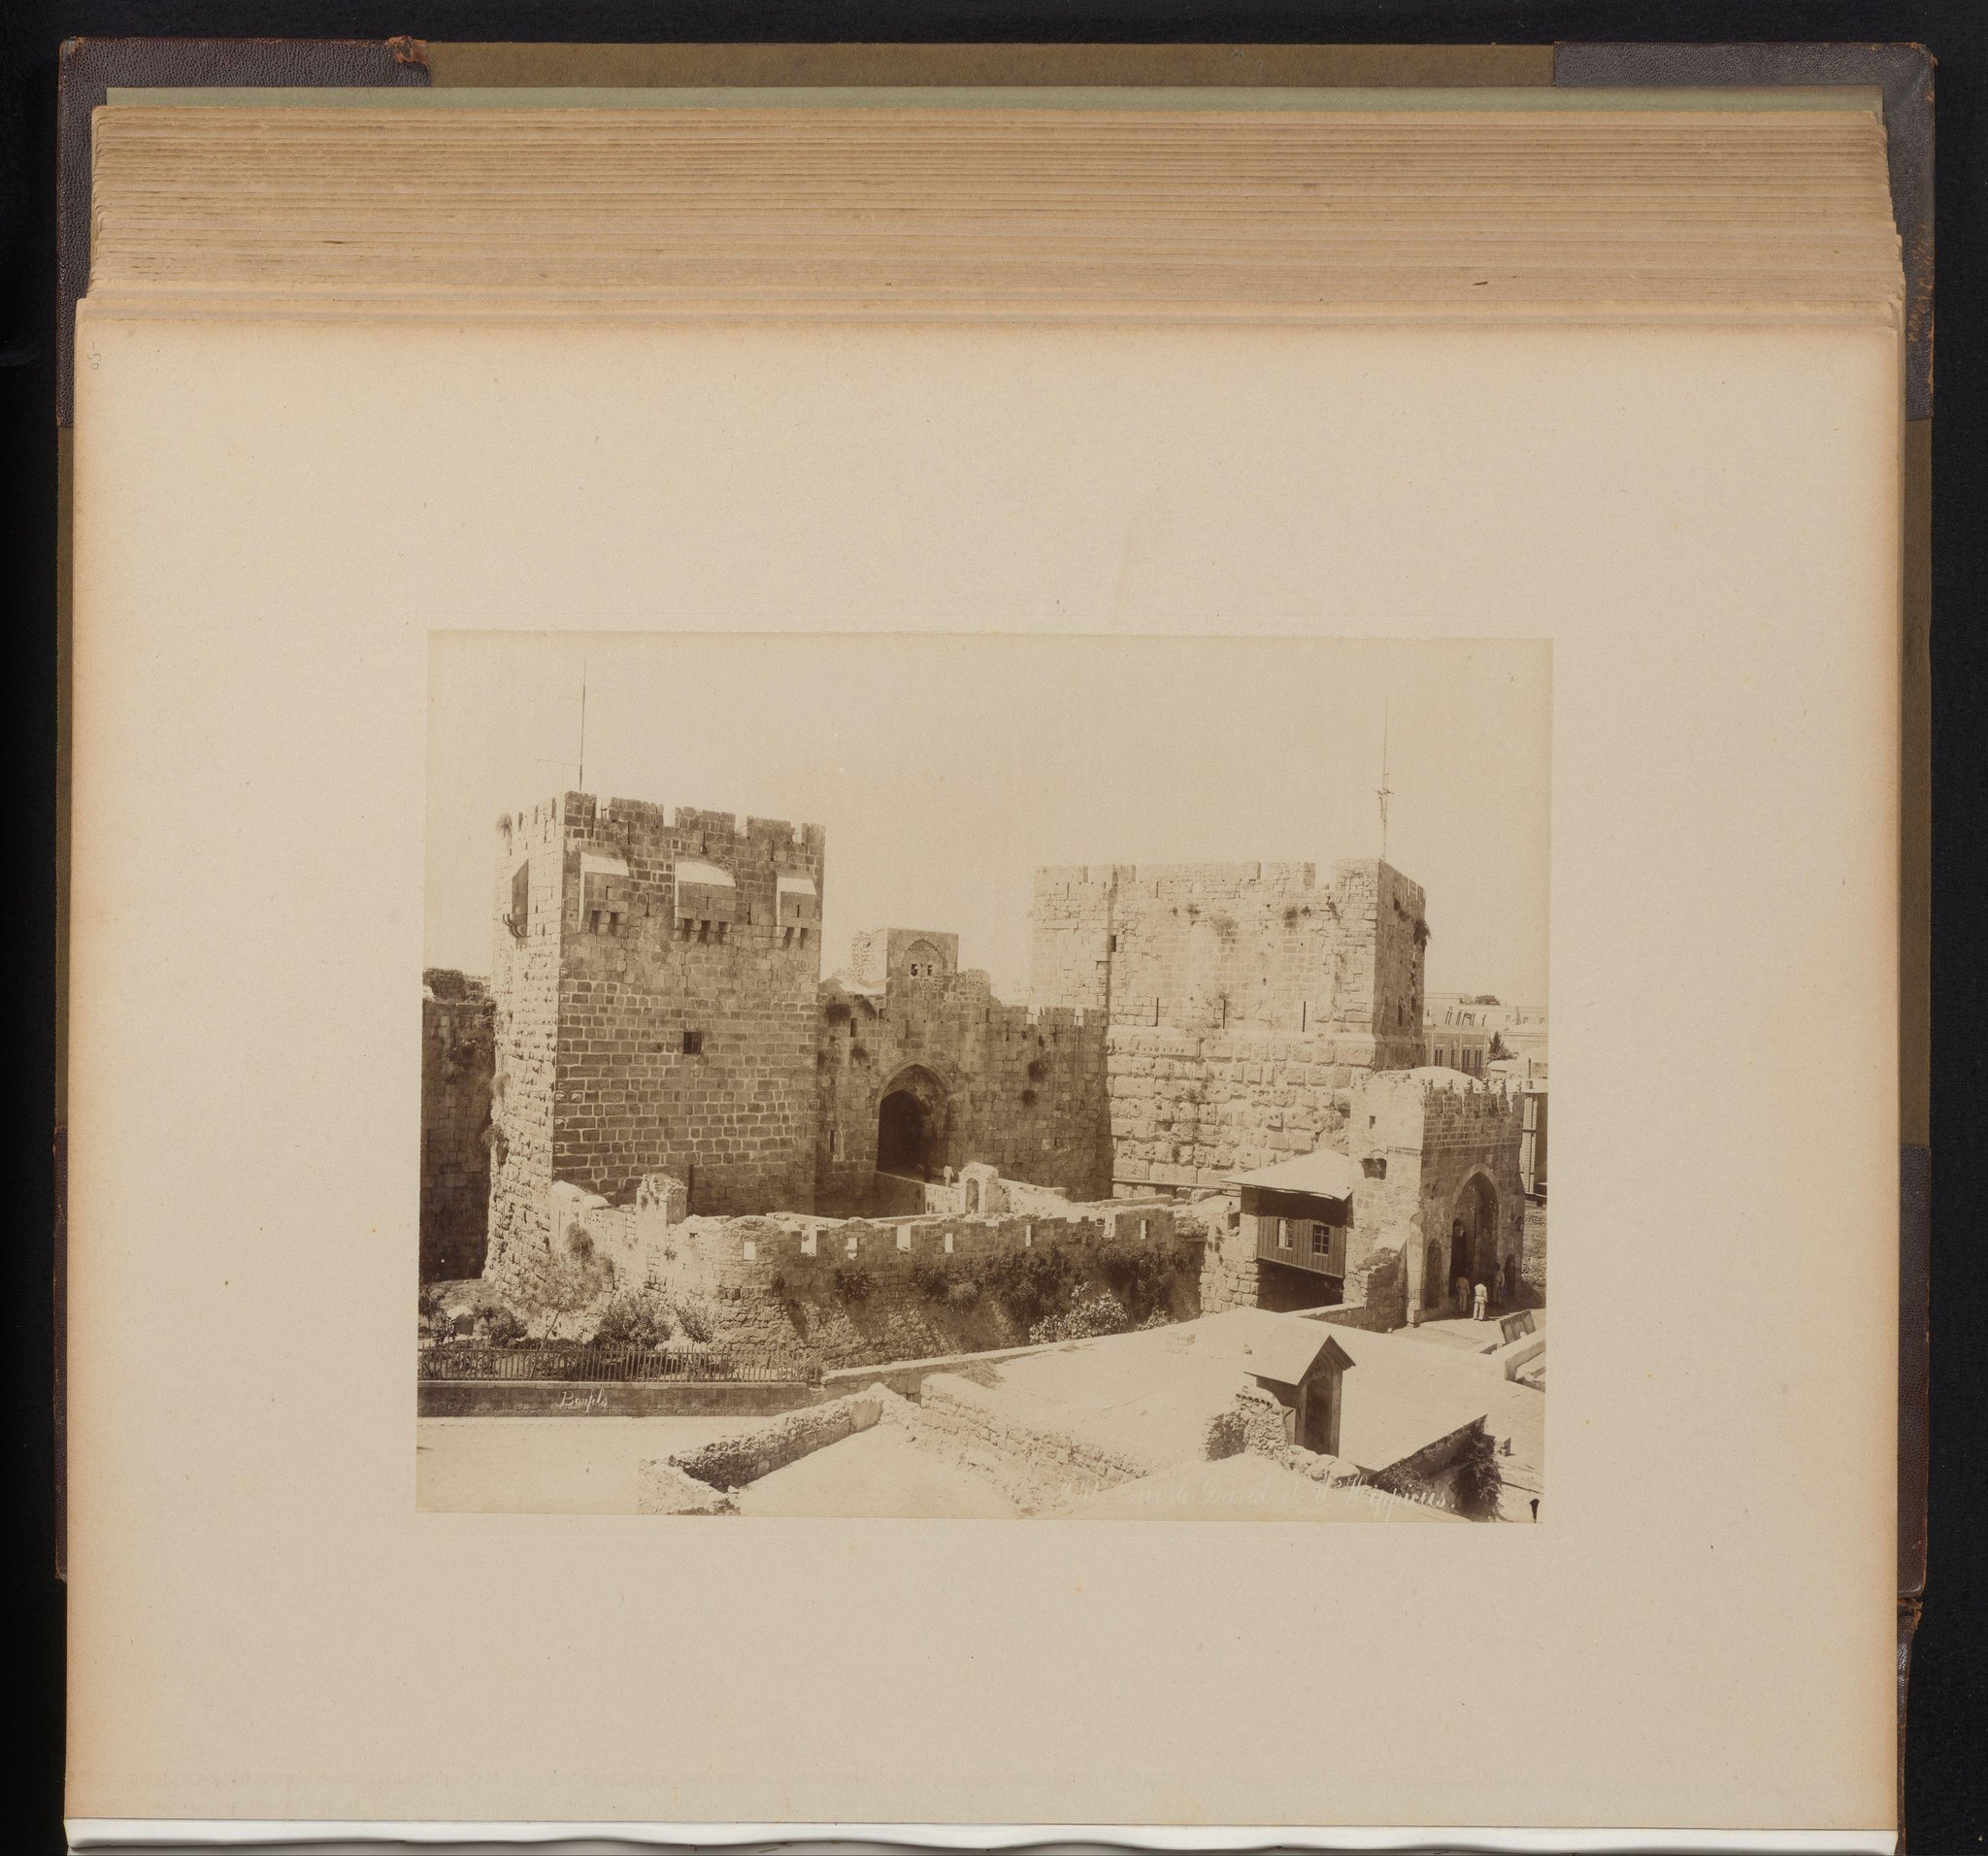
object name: photograph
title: Torens Phasaël en Hippicus in Jeruzalem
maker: félix bonfils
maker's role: fotograaf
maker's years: 1831-1885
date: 1867-1885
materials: paper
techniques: albumen print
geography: jerusalem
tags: towers ~ fortified city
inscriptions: number: ‘251 [?]’